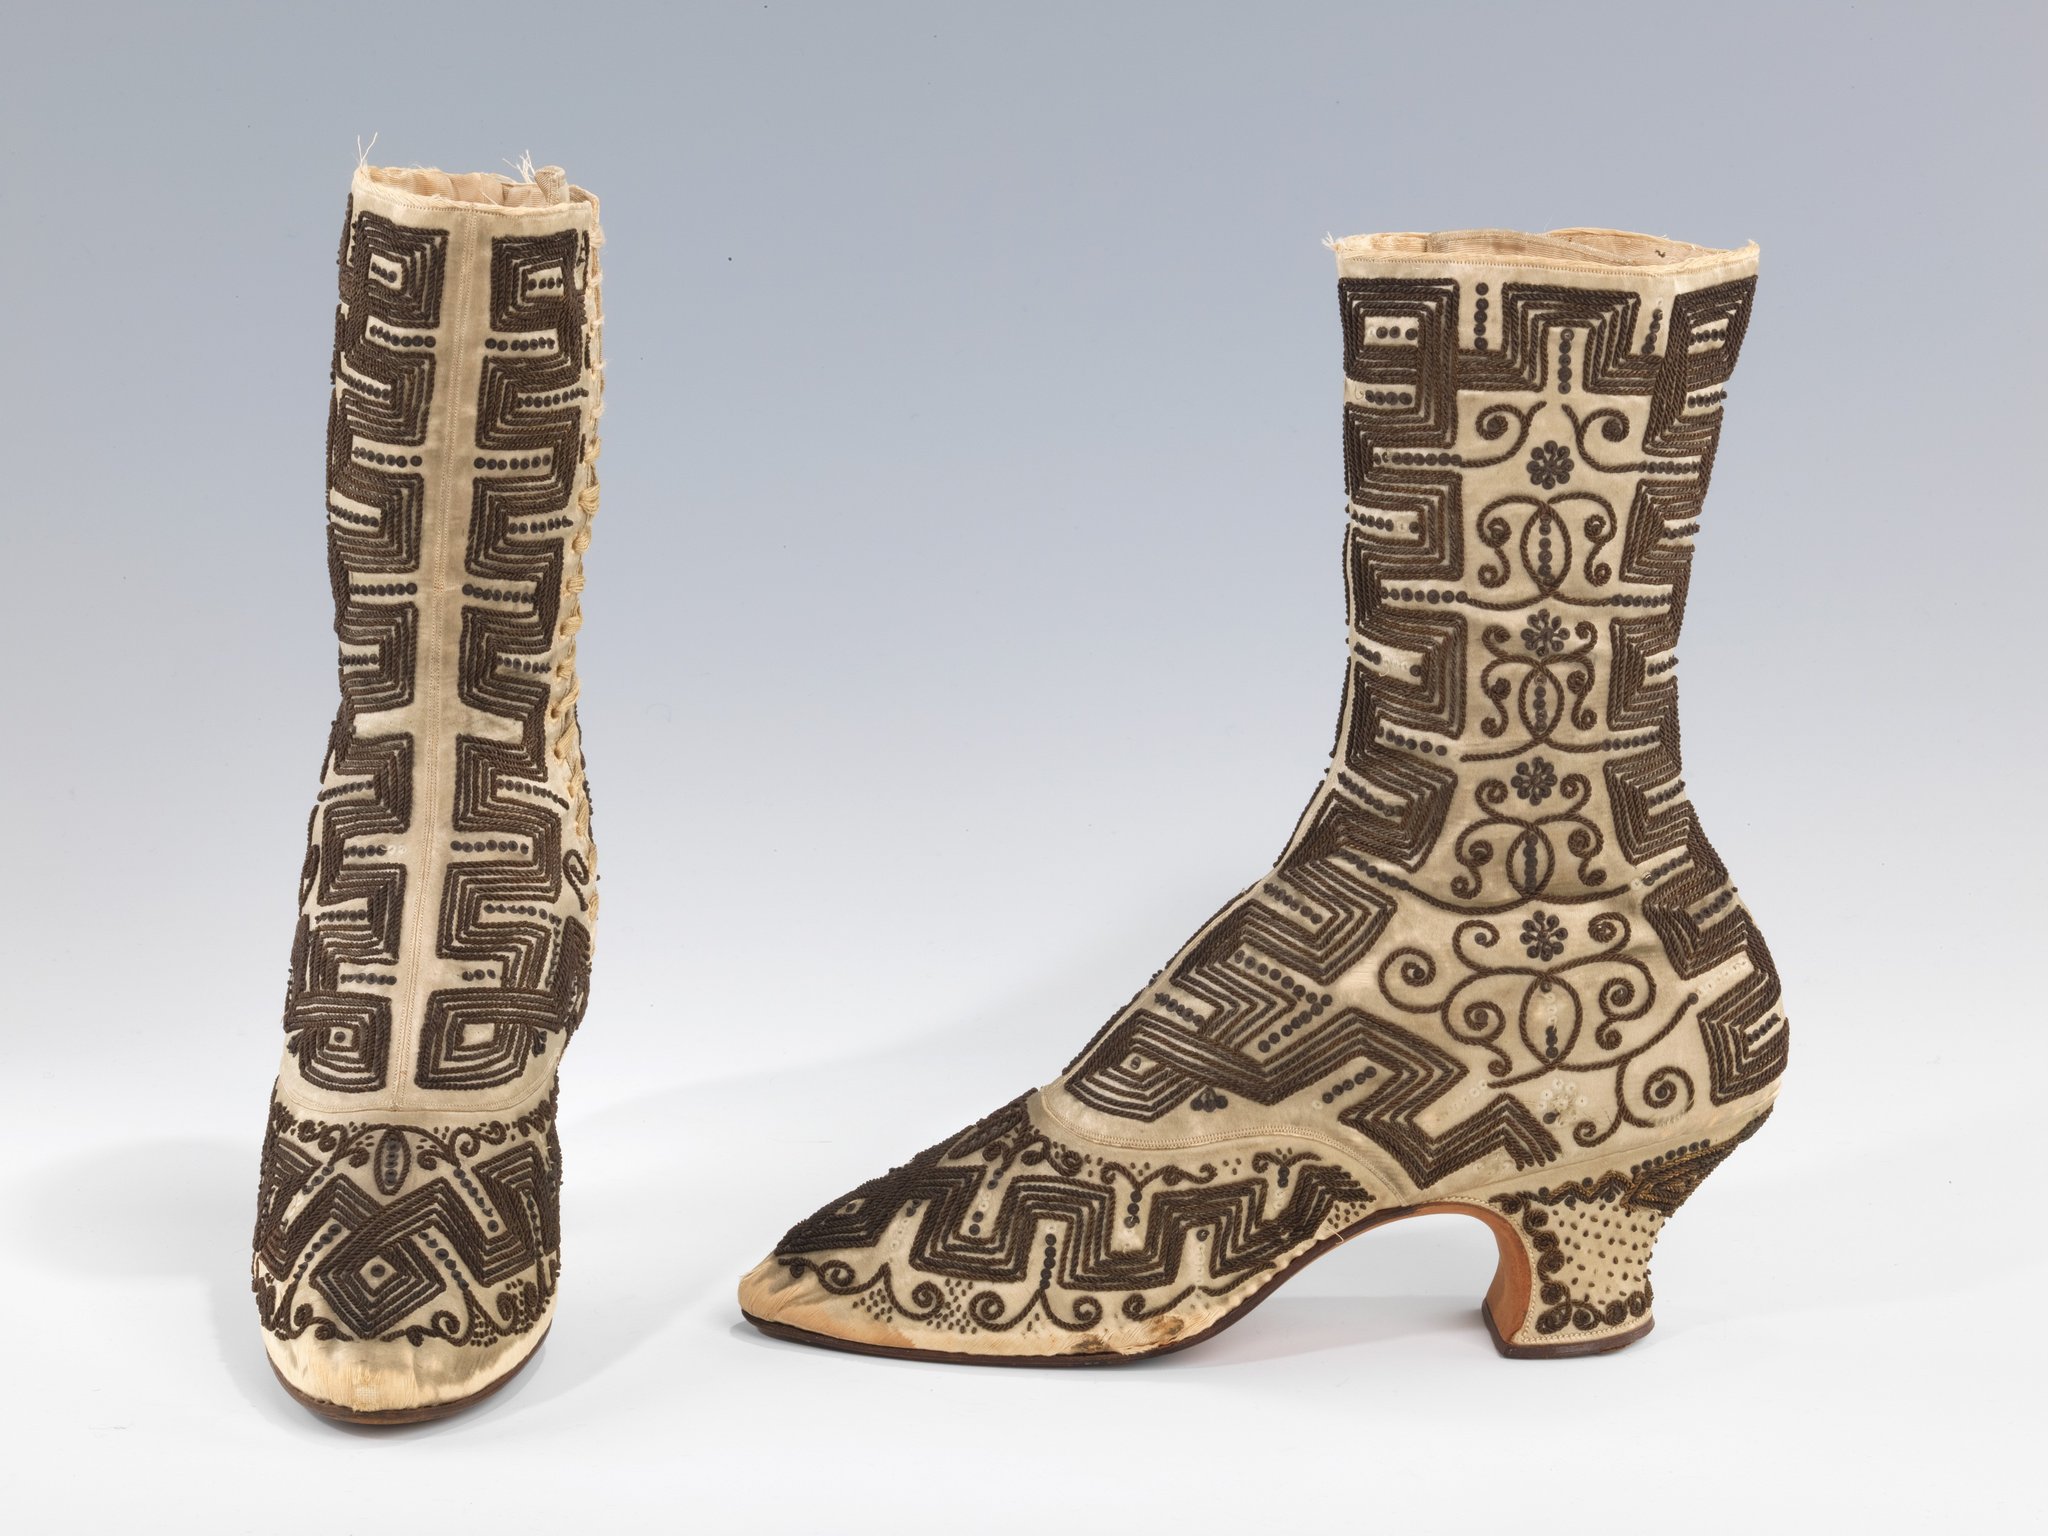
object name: evening boot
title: Evening boots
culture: french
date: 1885-1890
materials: metal, silk